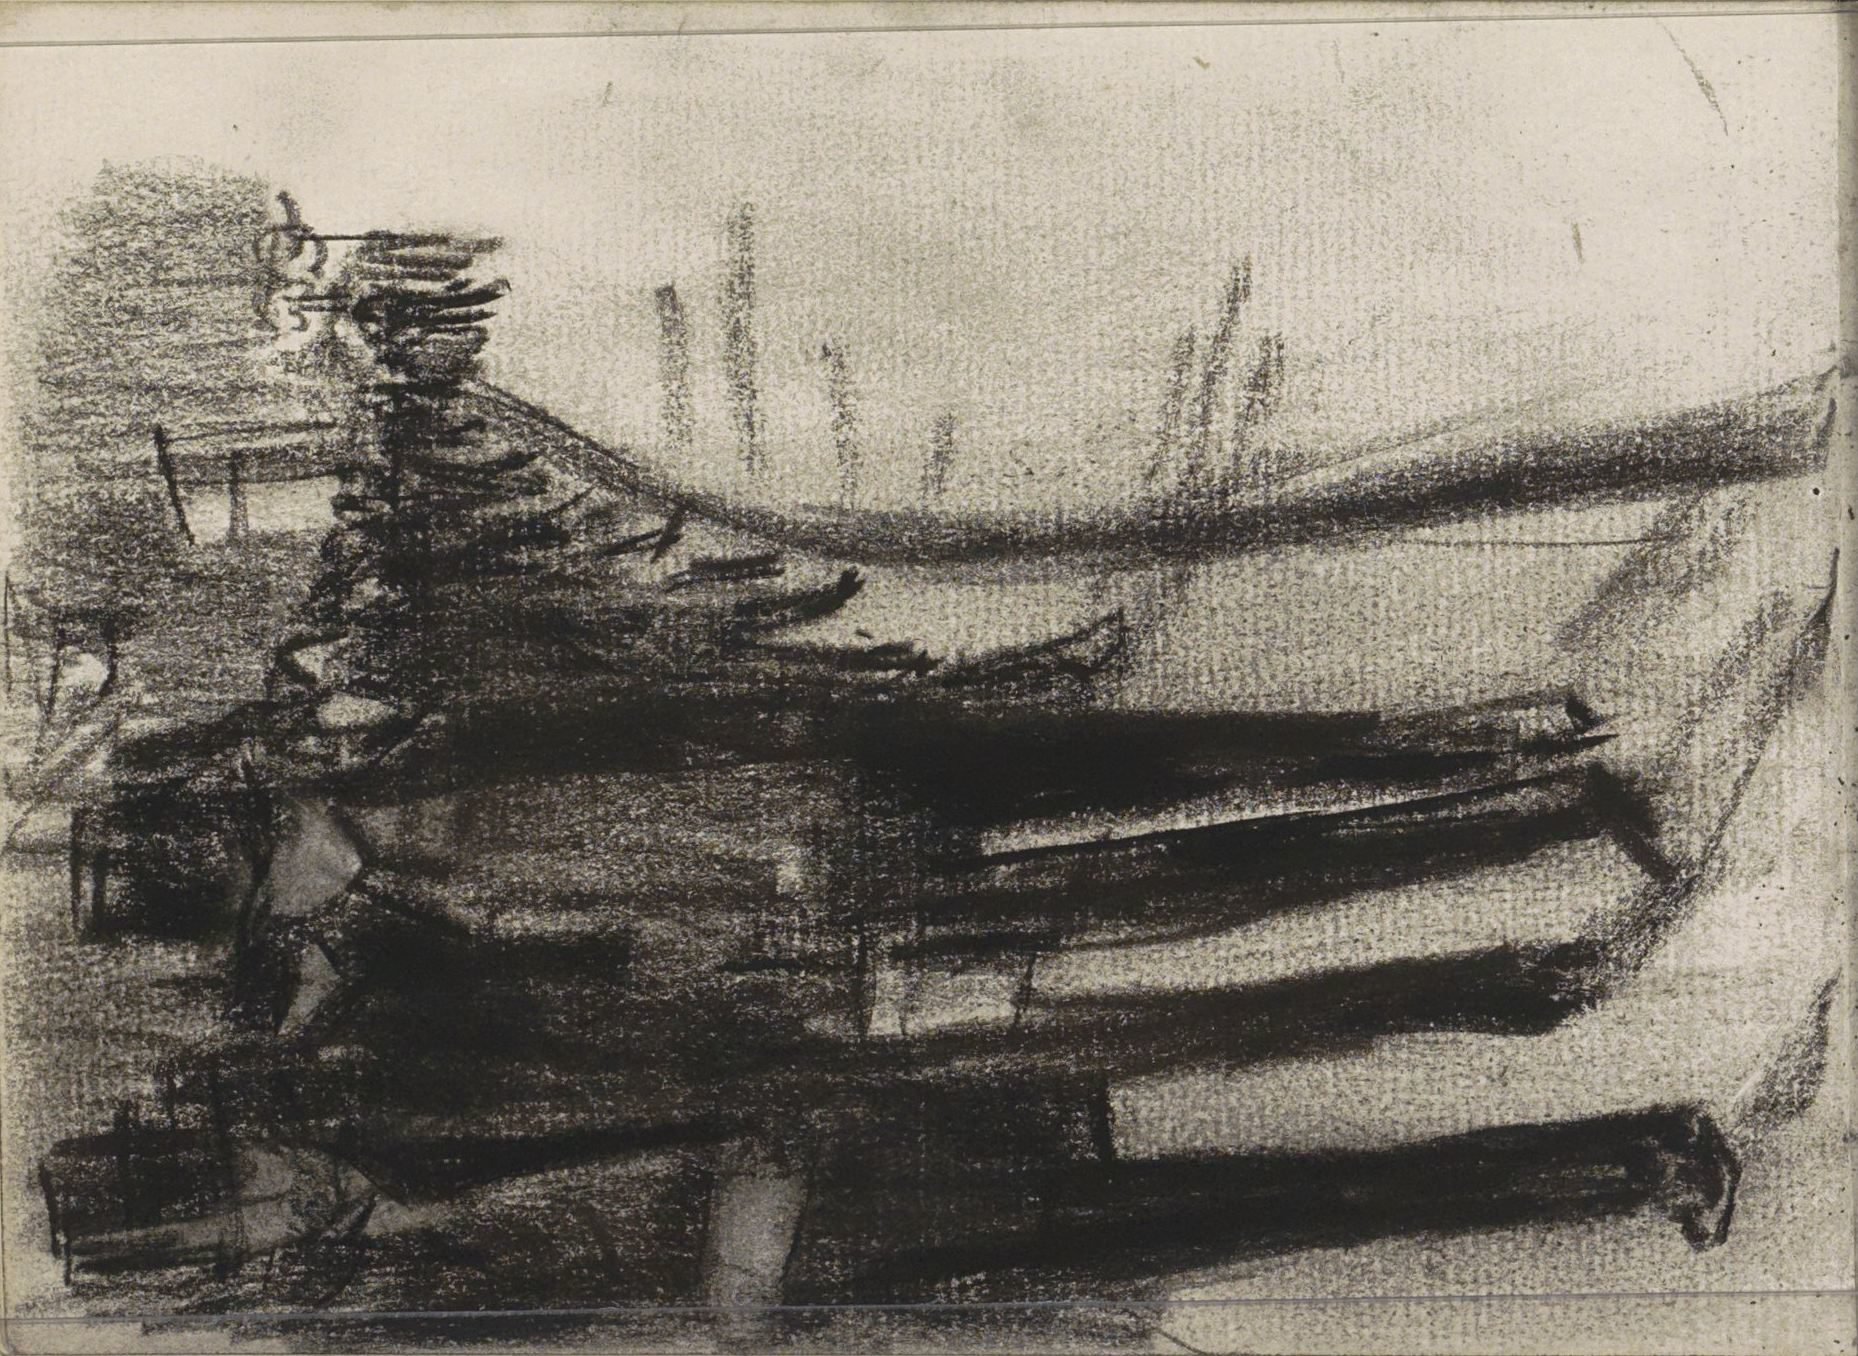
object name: sketchbook leaf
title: Stoet mensen op straat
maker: isaac israels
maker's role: draughtsman, painter, print maker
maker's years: 1865-1934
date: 1886-1903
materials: chalk, paper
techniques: stumping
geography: amsterdam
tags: adult man, street (+ city(-scape) with figures, staffage), head-gear: top hat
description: Vooraan twee mannen met hoge hoeden. Pagina 46 uit schetsboek XLVII met 52 pagina's.